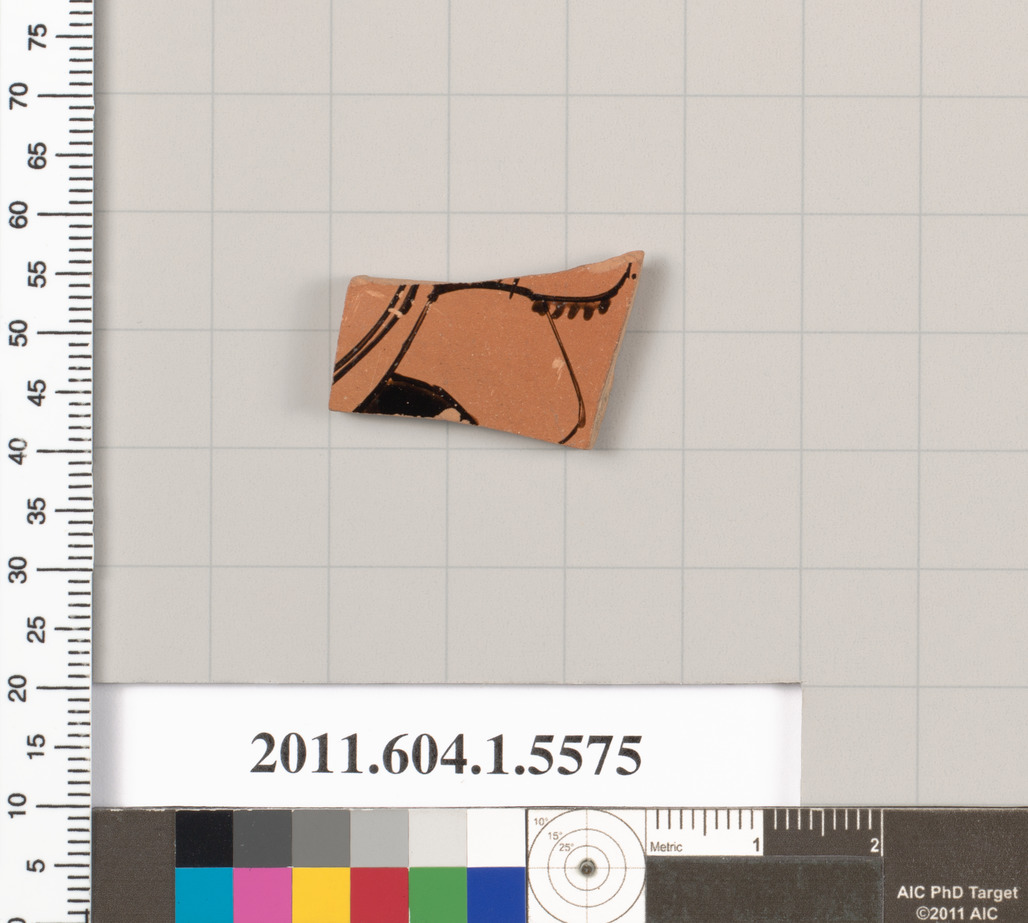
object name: kylix fragment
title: Terracotta fragment of a kylix (drinking cup)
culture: greek, attic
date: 520-500 BCE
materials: terracotta